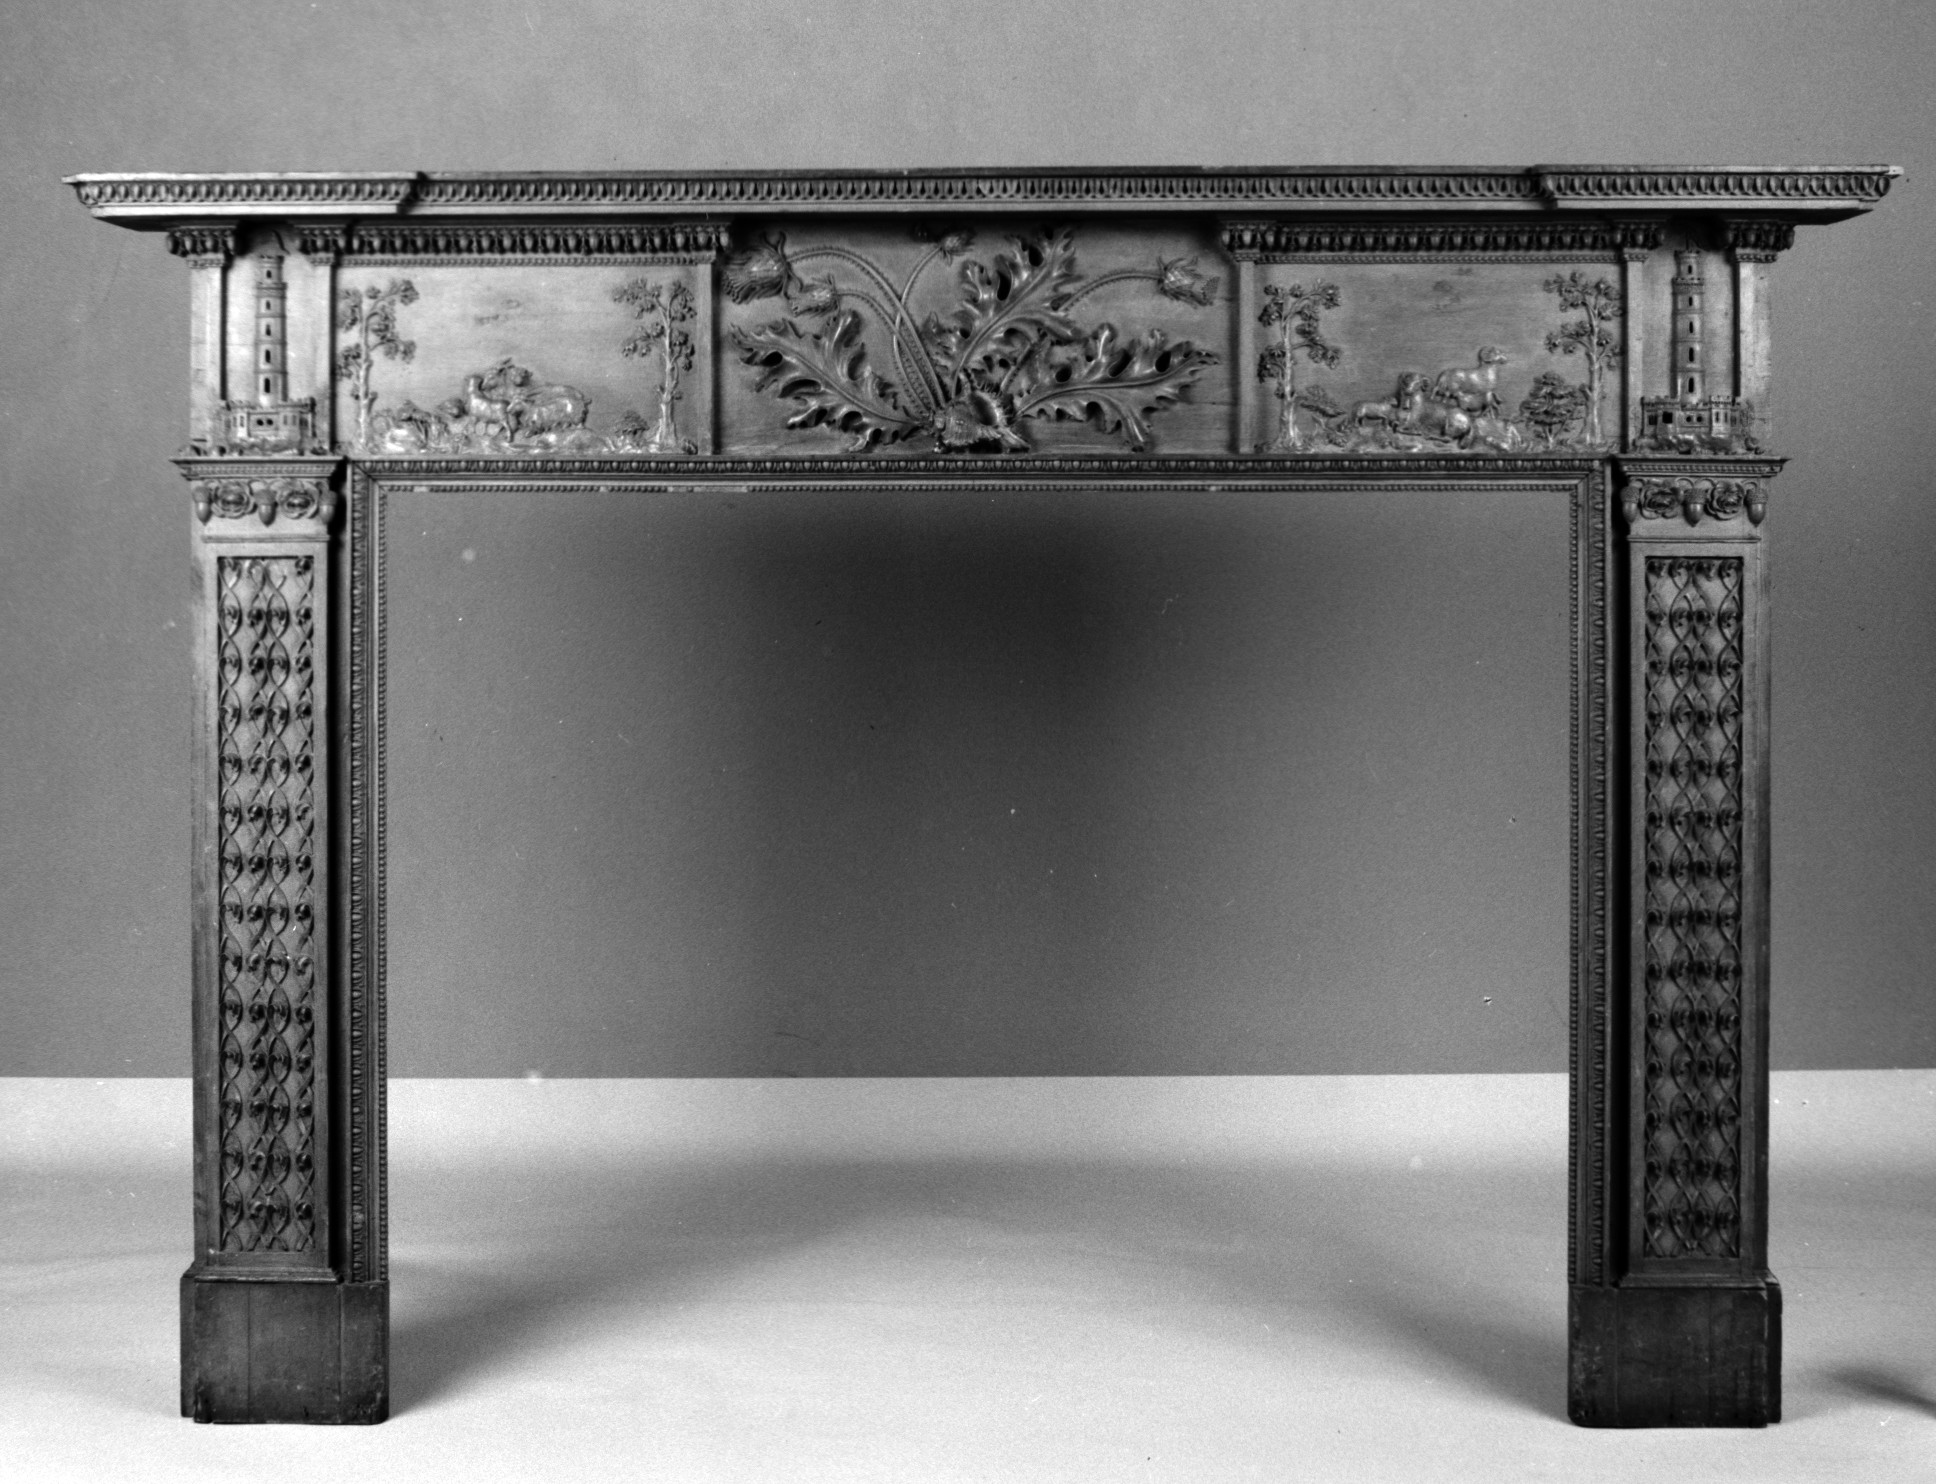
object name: chimneypiece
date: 1800